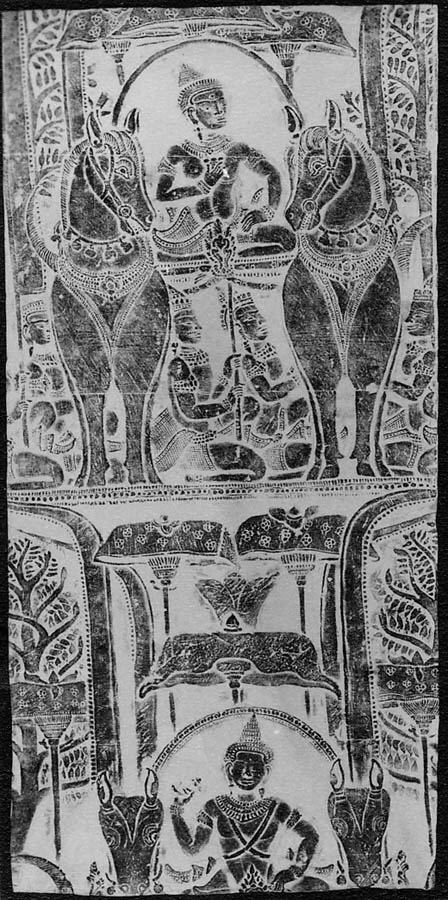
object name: rubbing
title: Rubbing of Surya, the Sun God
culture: cambodian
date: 1901-2000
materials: ink, paper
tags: men,horses